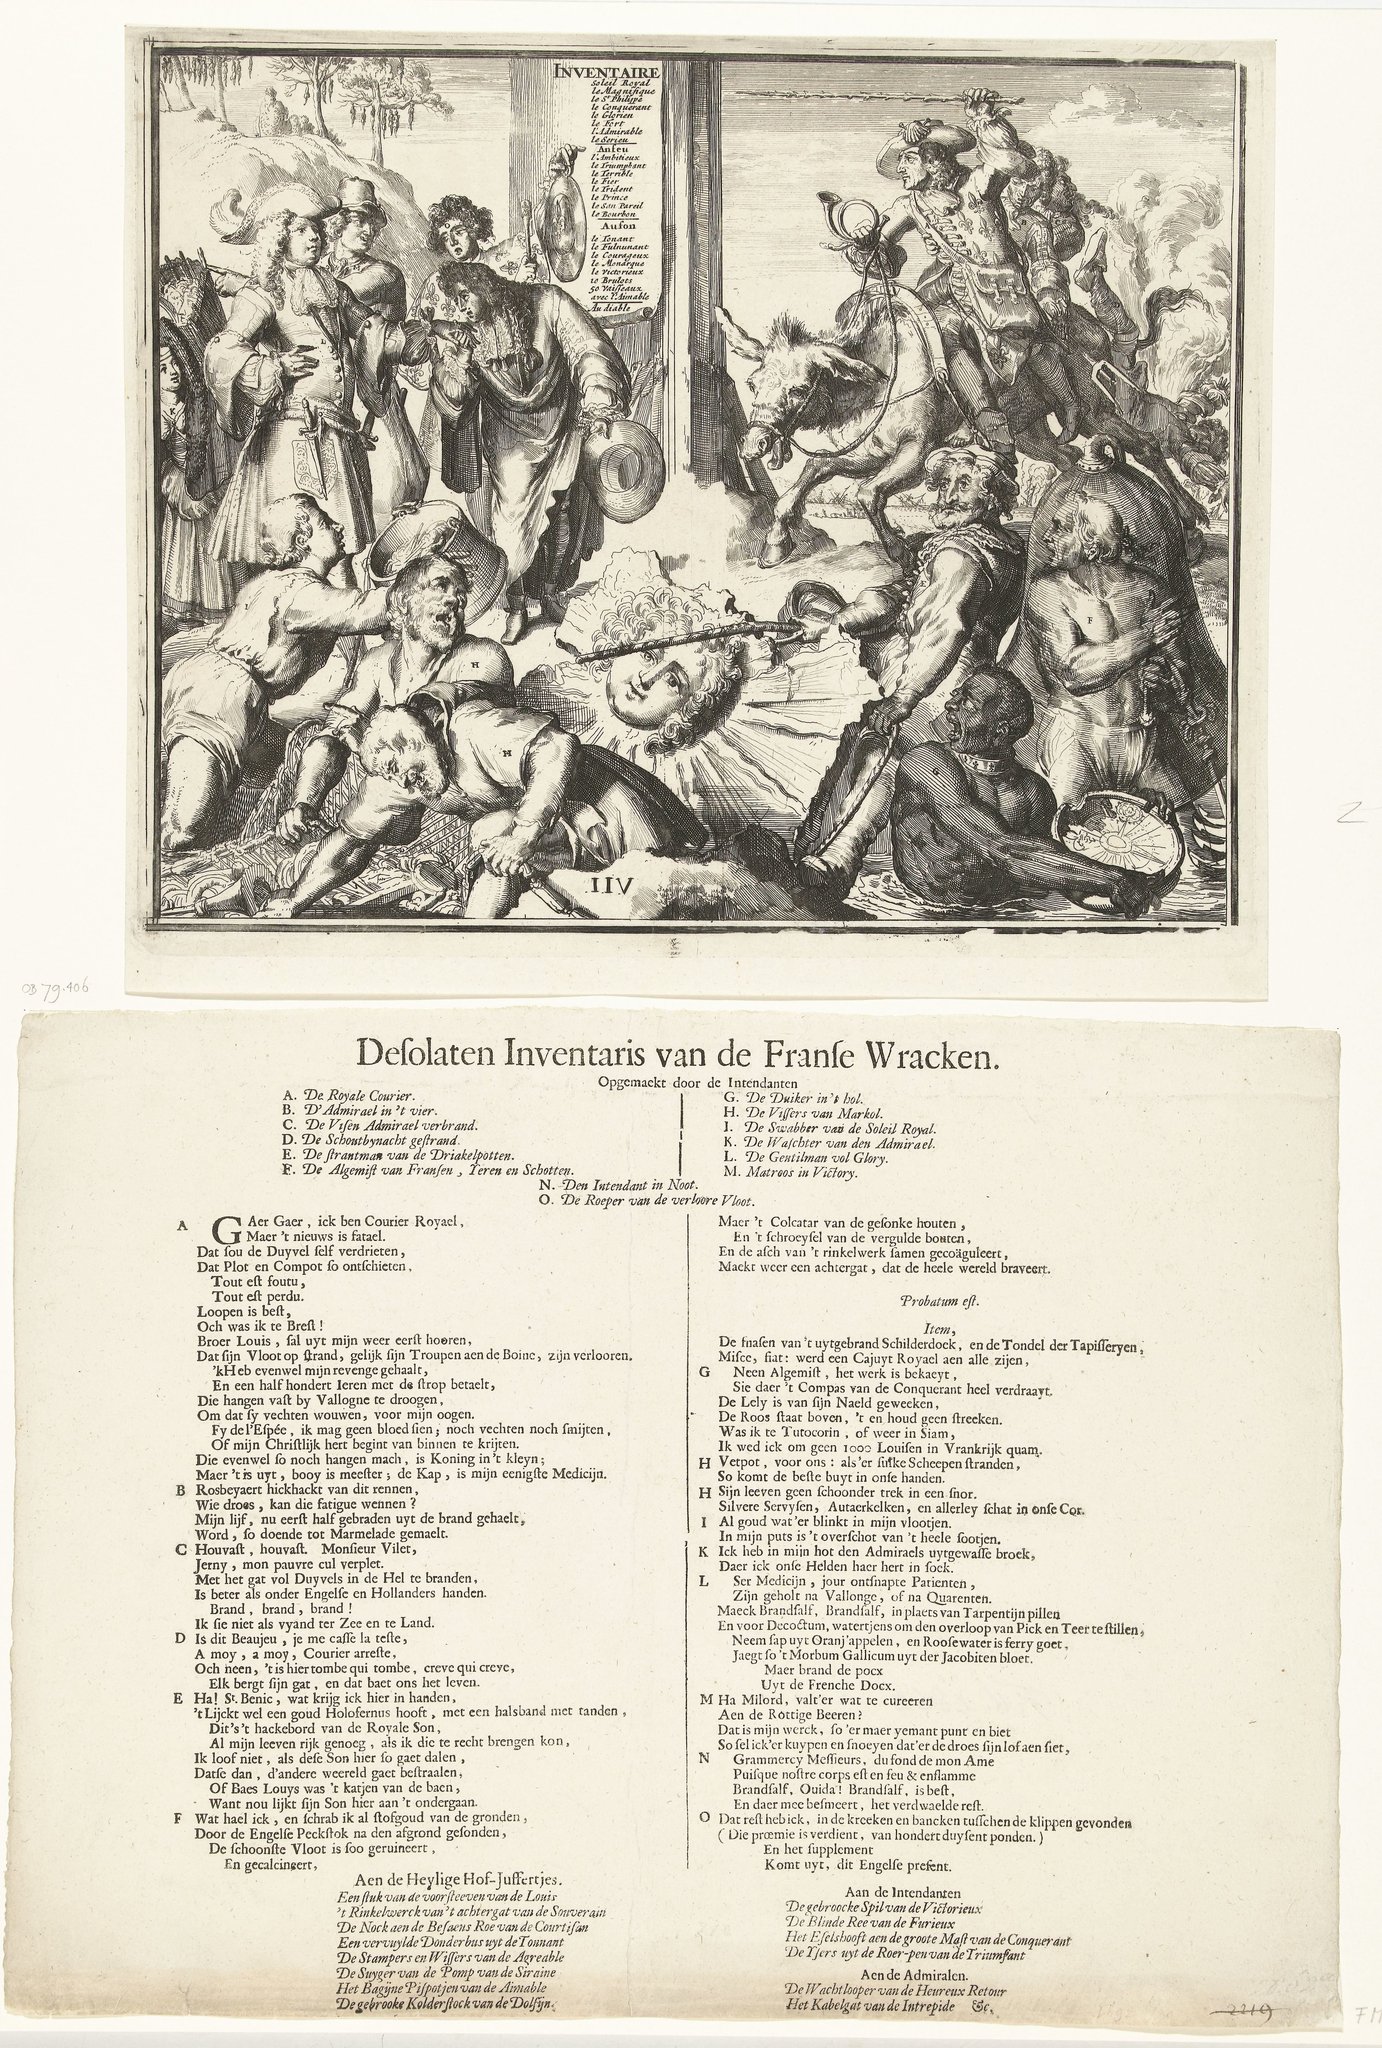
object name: print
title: Desolaten Inventaris van de Franse Wracken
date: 1692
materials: paper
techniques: etching, letterpress printing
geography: northern netherlands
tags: jacobus ii (koning van engeland en schotland), lodewijk xiv (koning van frankrijk), political caricatures and satires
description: Spotprent op de Franse nederlaag in de Slag bij Kaap la Hogue waarbij de Fransen onder admiraal de Tourville werden verslagen door de gecombineerde vloot van Engeland en Holland onder de admiralen Russel en Almonde, 29 mei t/m 3 juni 1692. Jacobus II komt als koerier op een ezel aangesneld met het nieuws van de Franse nederlaag. Links laat de victorieuse Engelsman (admiraal Russel?) zich de hand kussen, achter hem de Hollandse Matroos. Op de grond een verbrijzeld reliëf van de zonnegod. Bovenaan een lijst van de verloren geraakte Franse schepen. Bij de prent een los tekstblad met een spotvers met een toelichting op de letters A-O in 2 kolommen in het Nederlands.